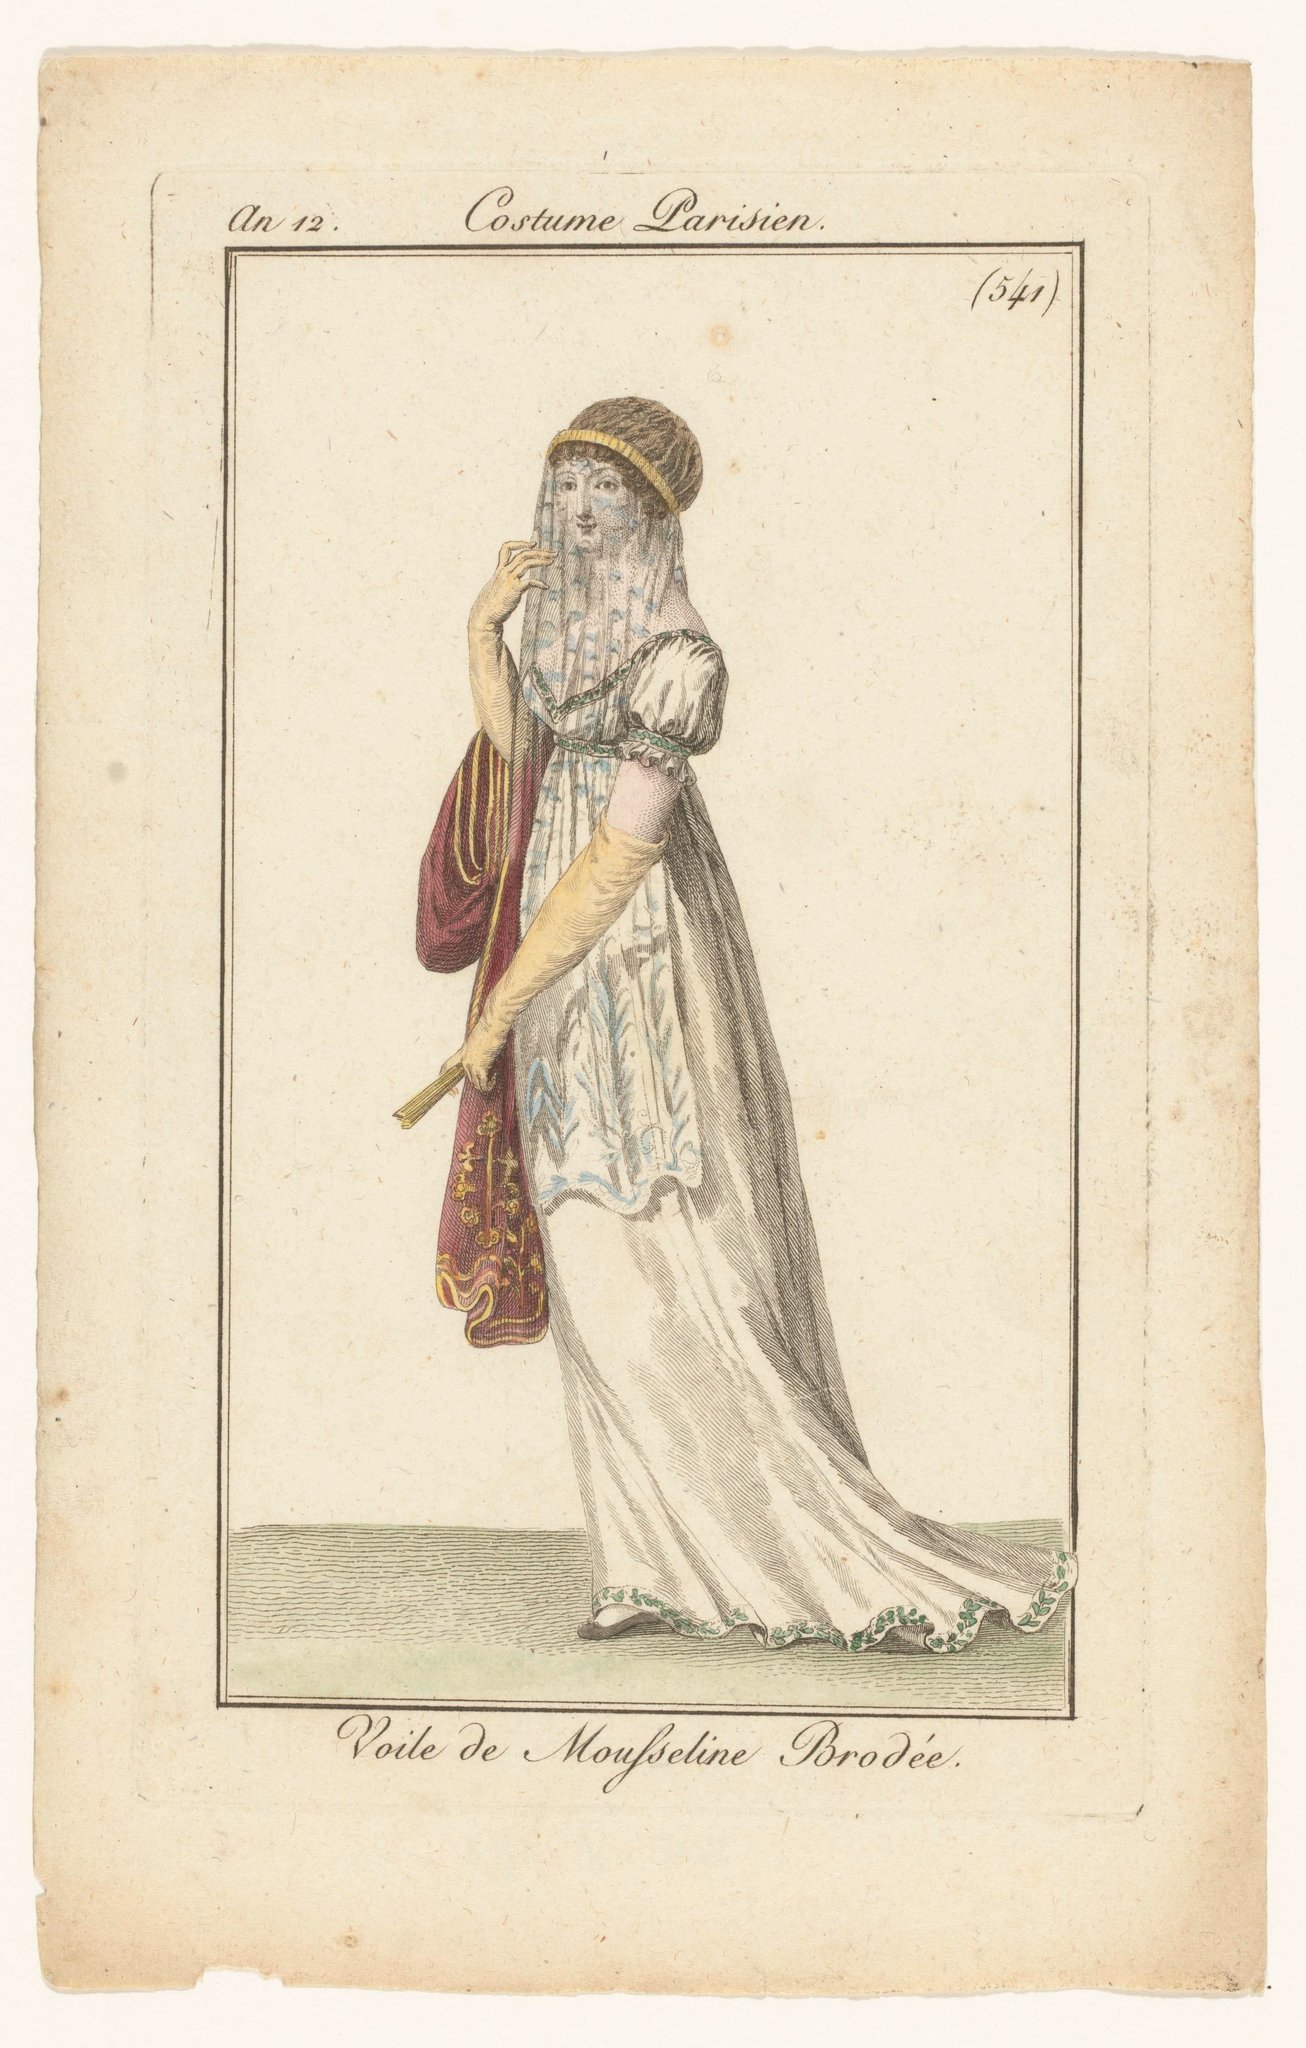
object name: fashion print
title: Journal des Dames et des modes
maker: Anonymous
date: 1803-1804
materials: paper, ink, watercolor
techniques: etching, hand coloring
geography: france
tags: fashion plates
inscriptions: collector's mark: Lugt 2228